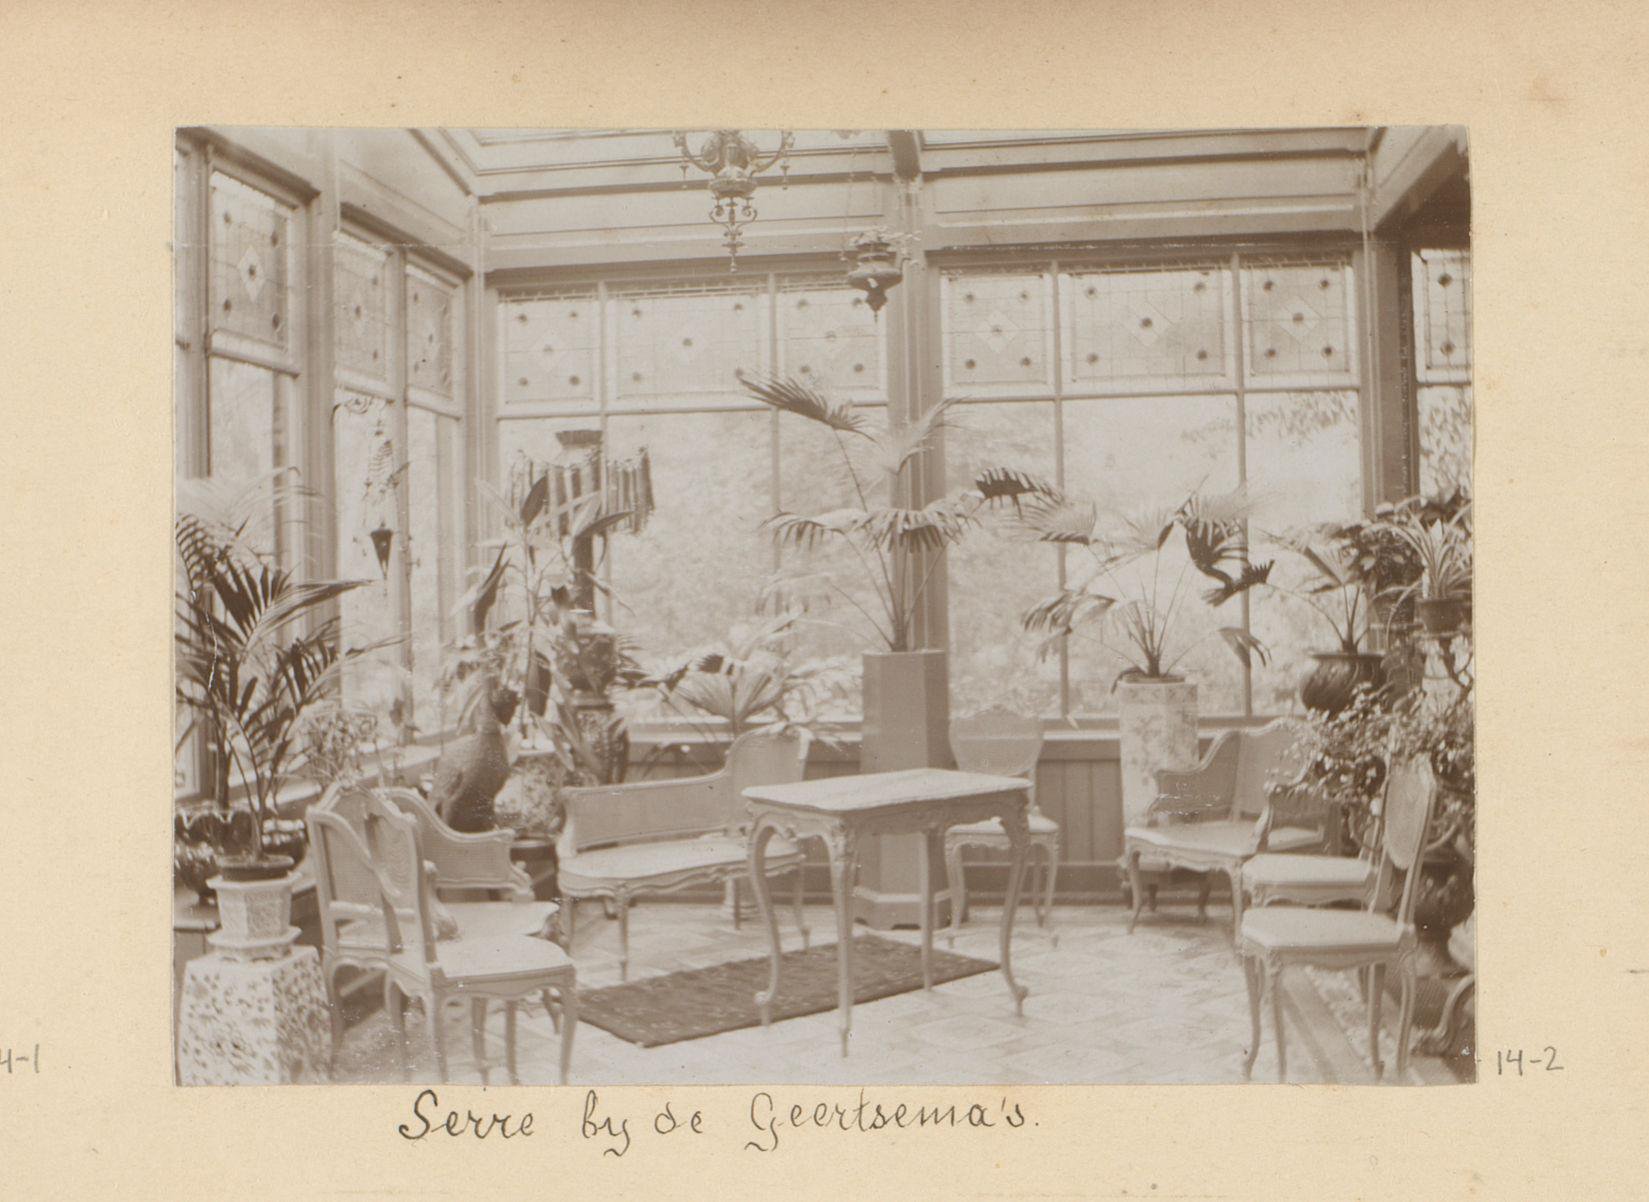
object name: album leaf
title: Serre bij de Geertsema's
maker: hendrik herman van den berg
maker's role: amateurfotograaf, jurist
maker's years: 1875-1944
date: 1890-1894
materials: paper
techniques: collodion silver print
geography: amsterdam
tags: winter-garden, conservatory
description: Foto 2 op albumblad 14 uit album "Amsterdam 1890-1894".